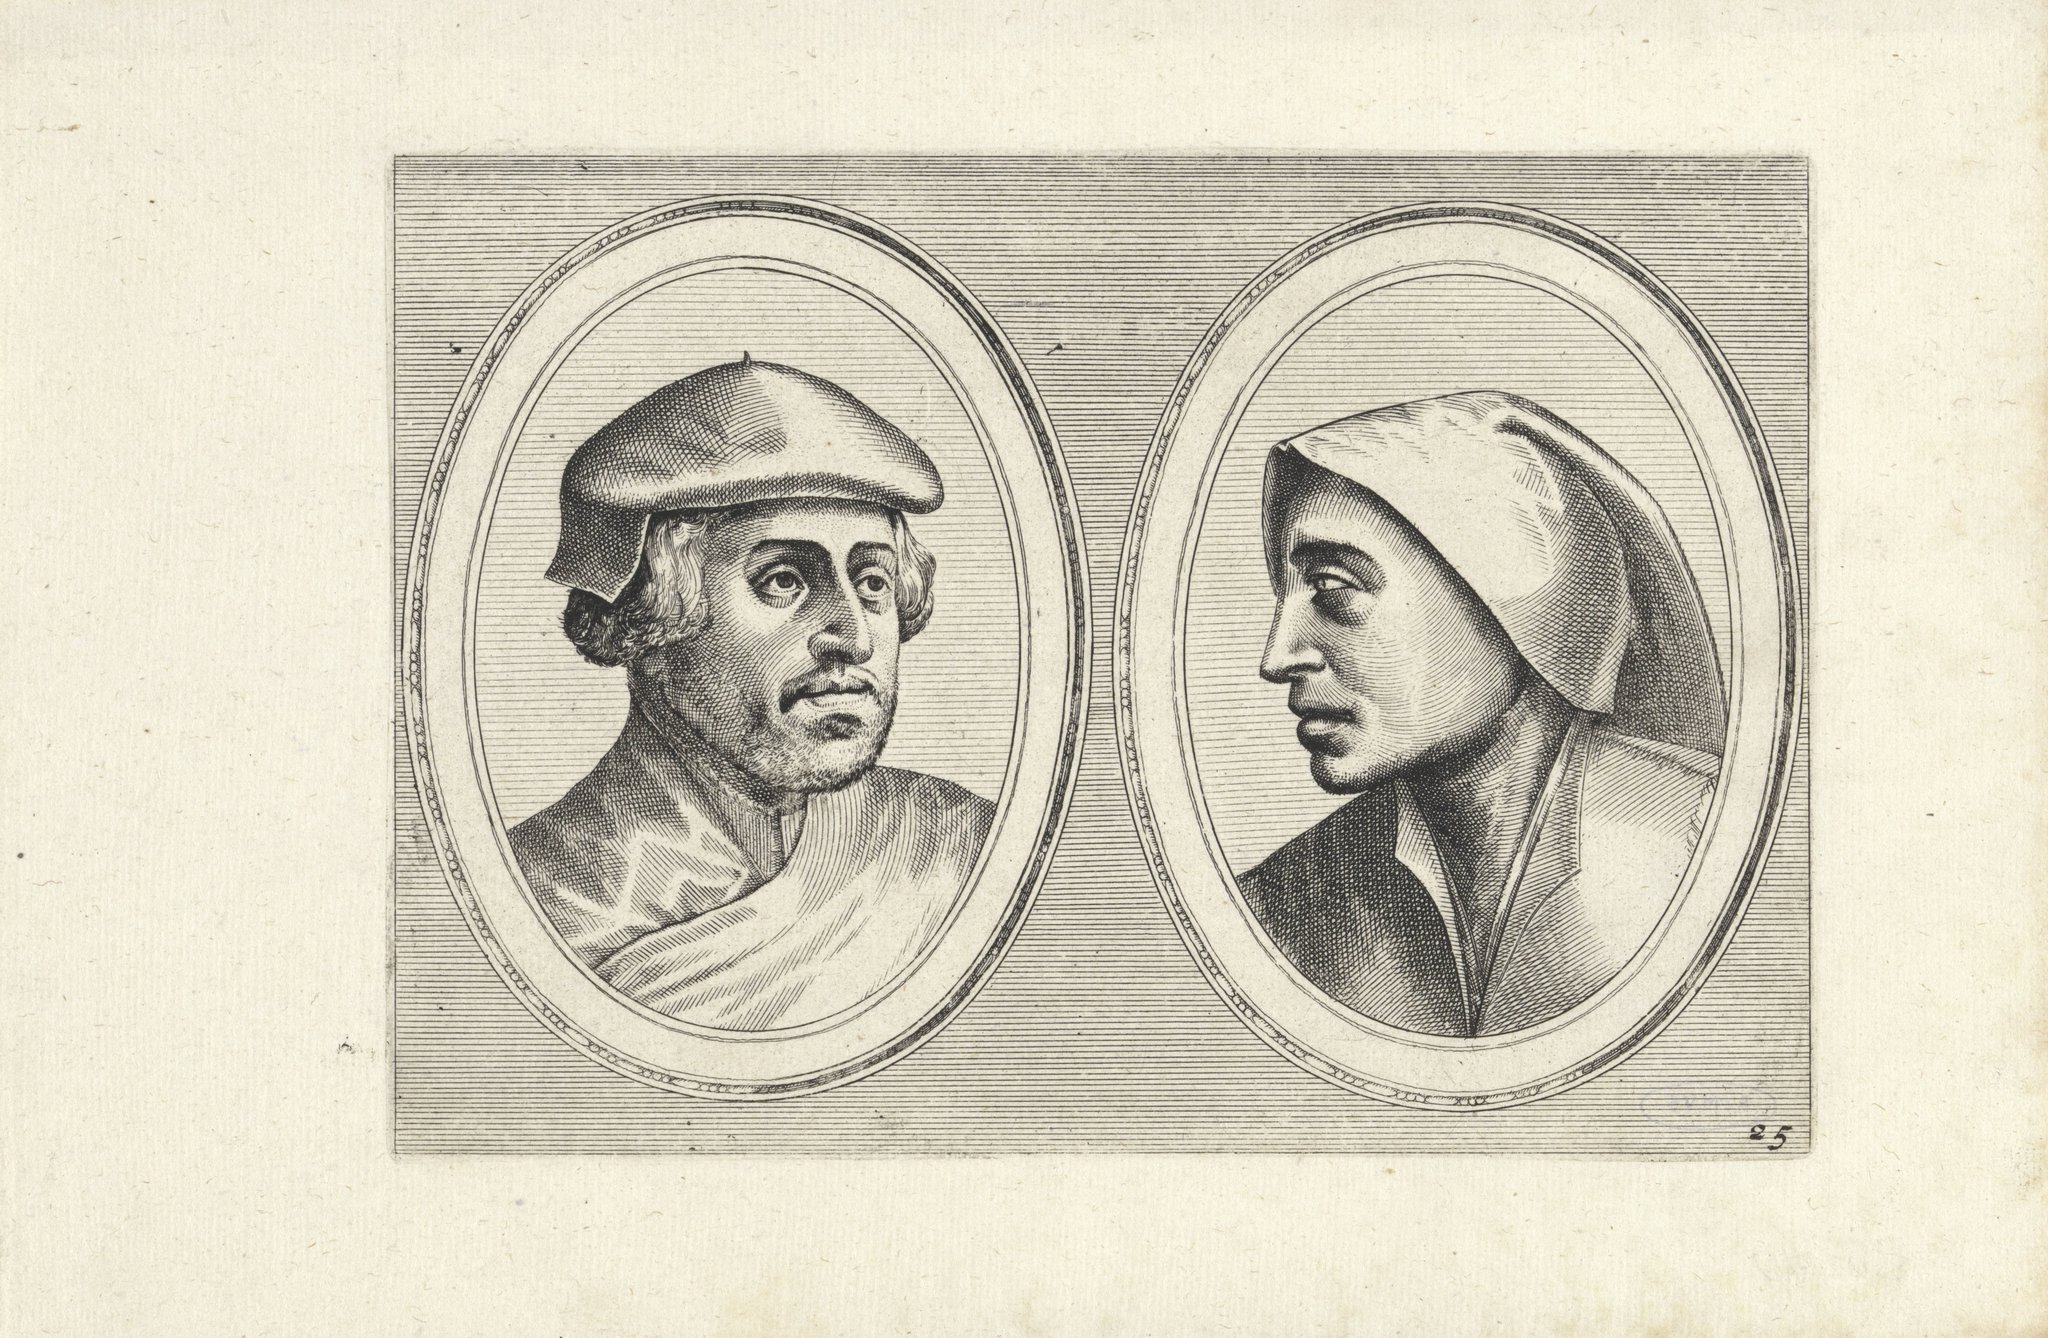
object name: print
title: Oprechte Lammert en Deughdighe Geertruyd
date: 1612-1652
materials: paper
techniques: engraving, etching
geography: amsterdam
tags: head-gear, farmers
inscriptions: collector's mark: Lugt 2228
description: Prent uit een serie van 36 prenten met koppen van boeren en boerinnen.